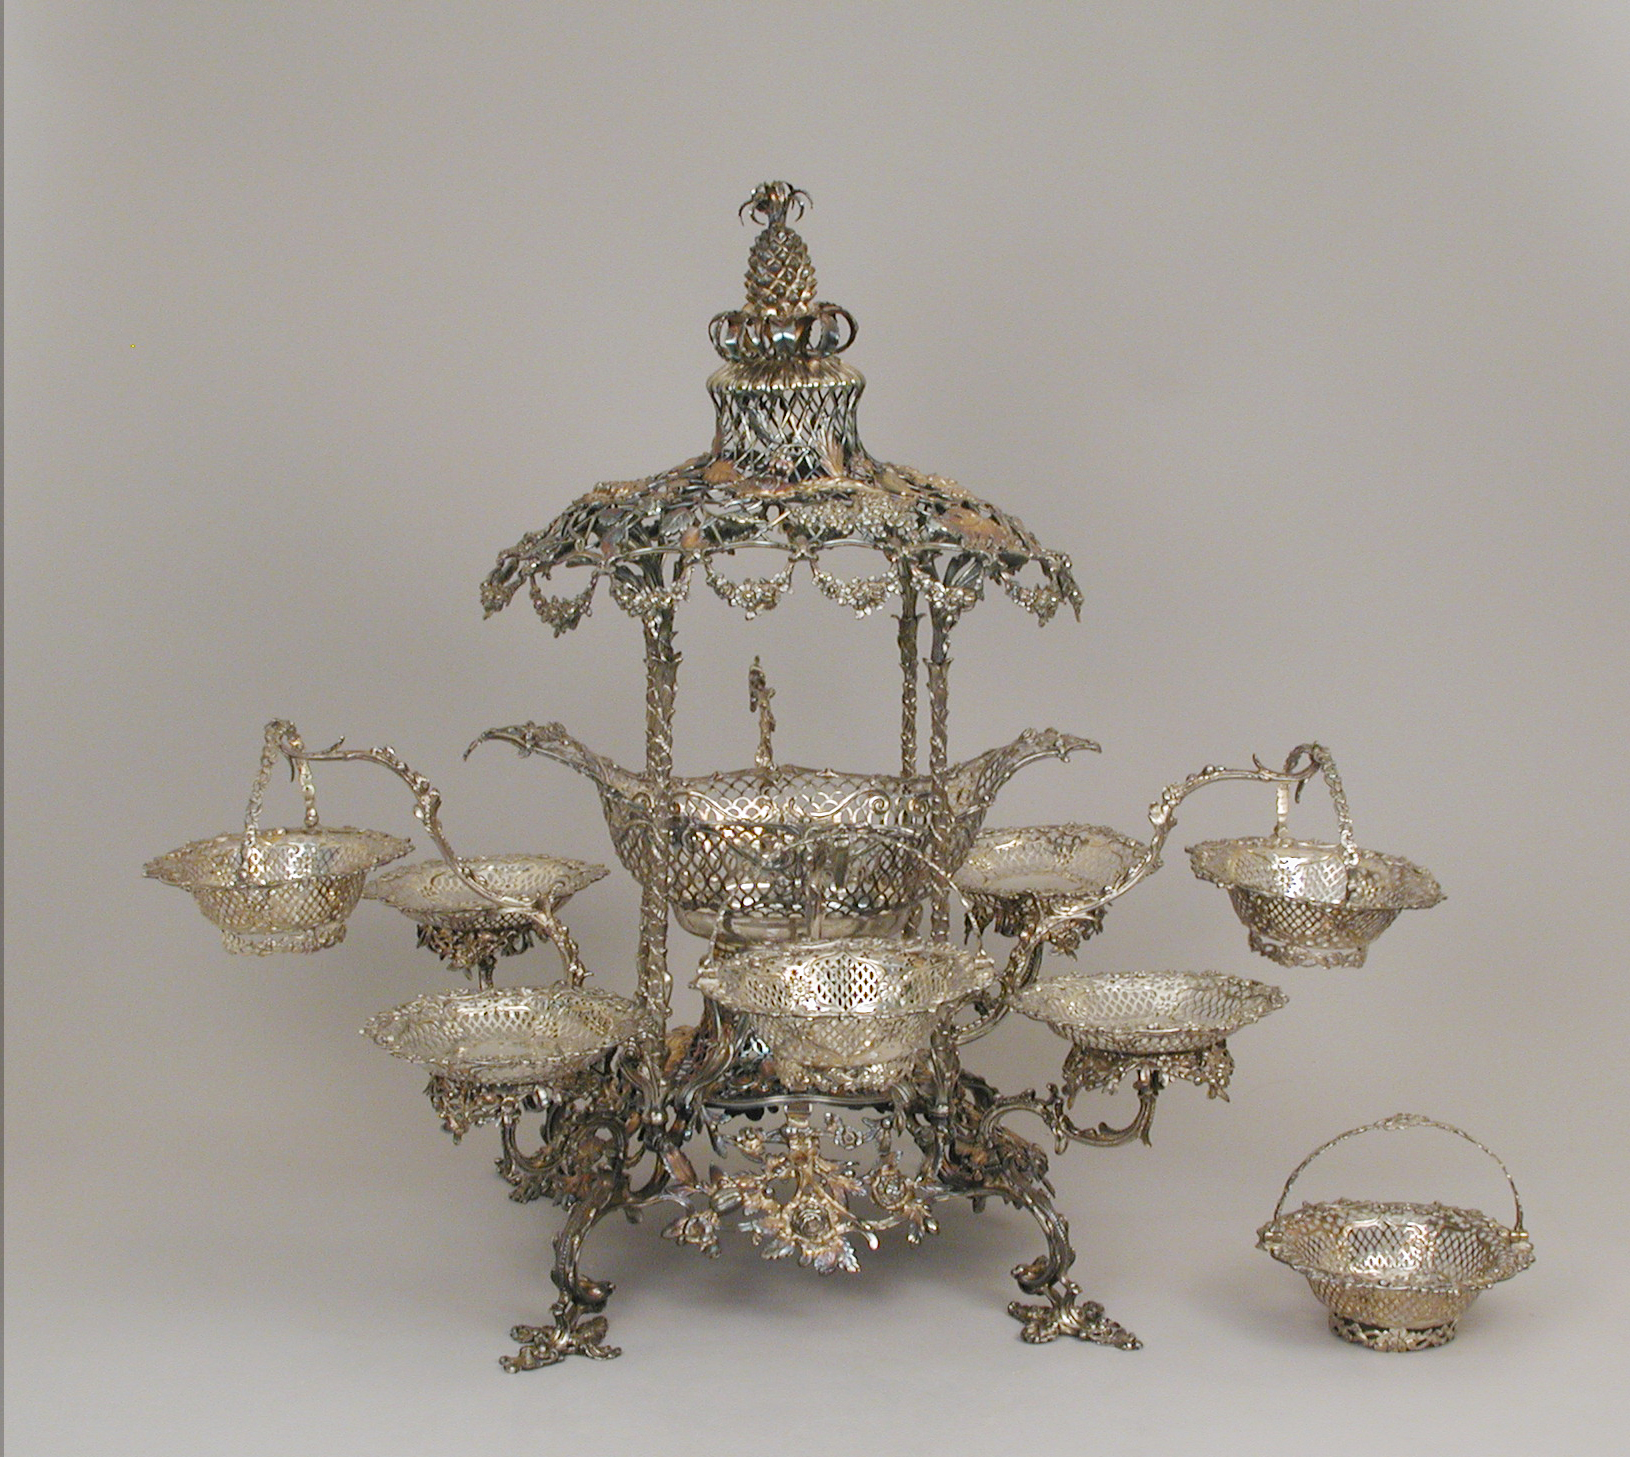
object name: epergne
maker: thomas heming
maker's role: maker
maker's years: 1745-1773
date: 1766-1767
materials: silver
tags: flowers